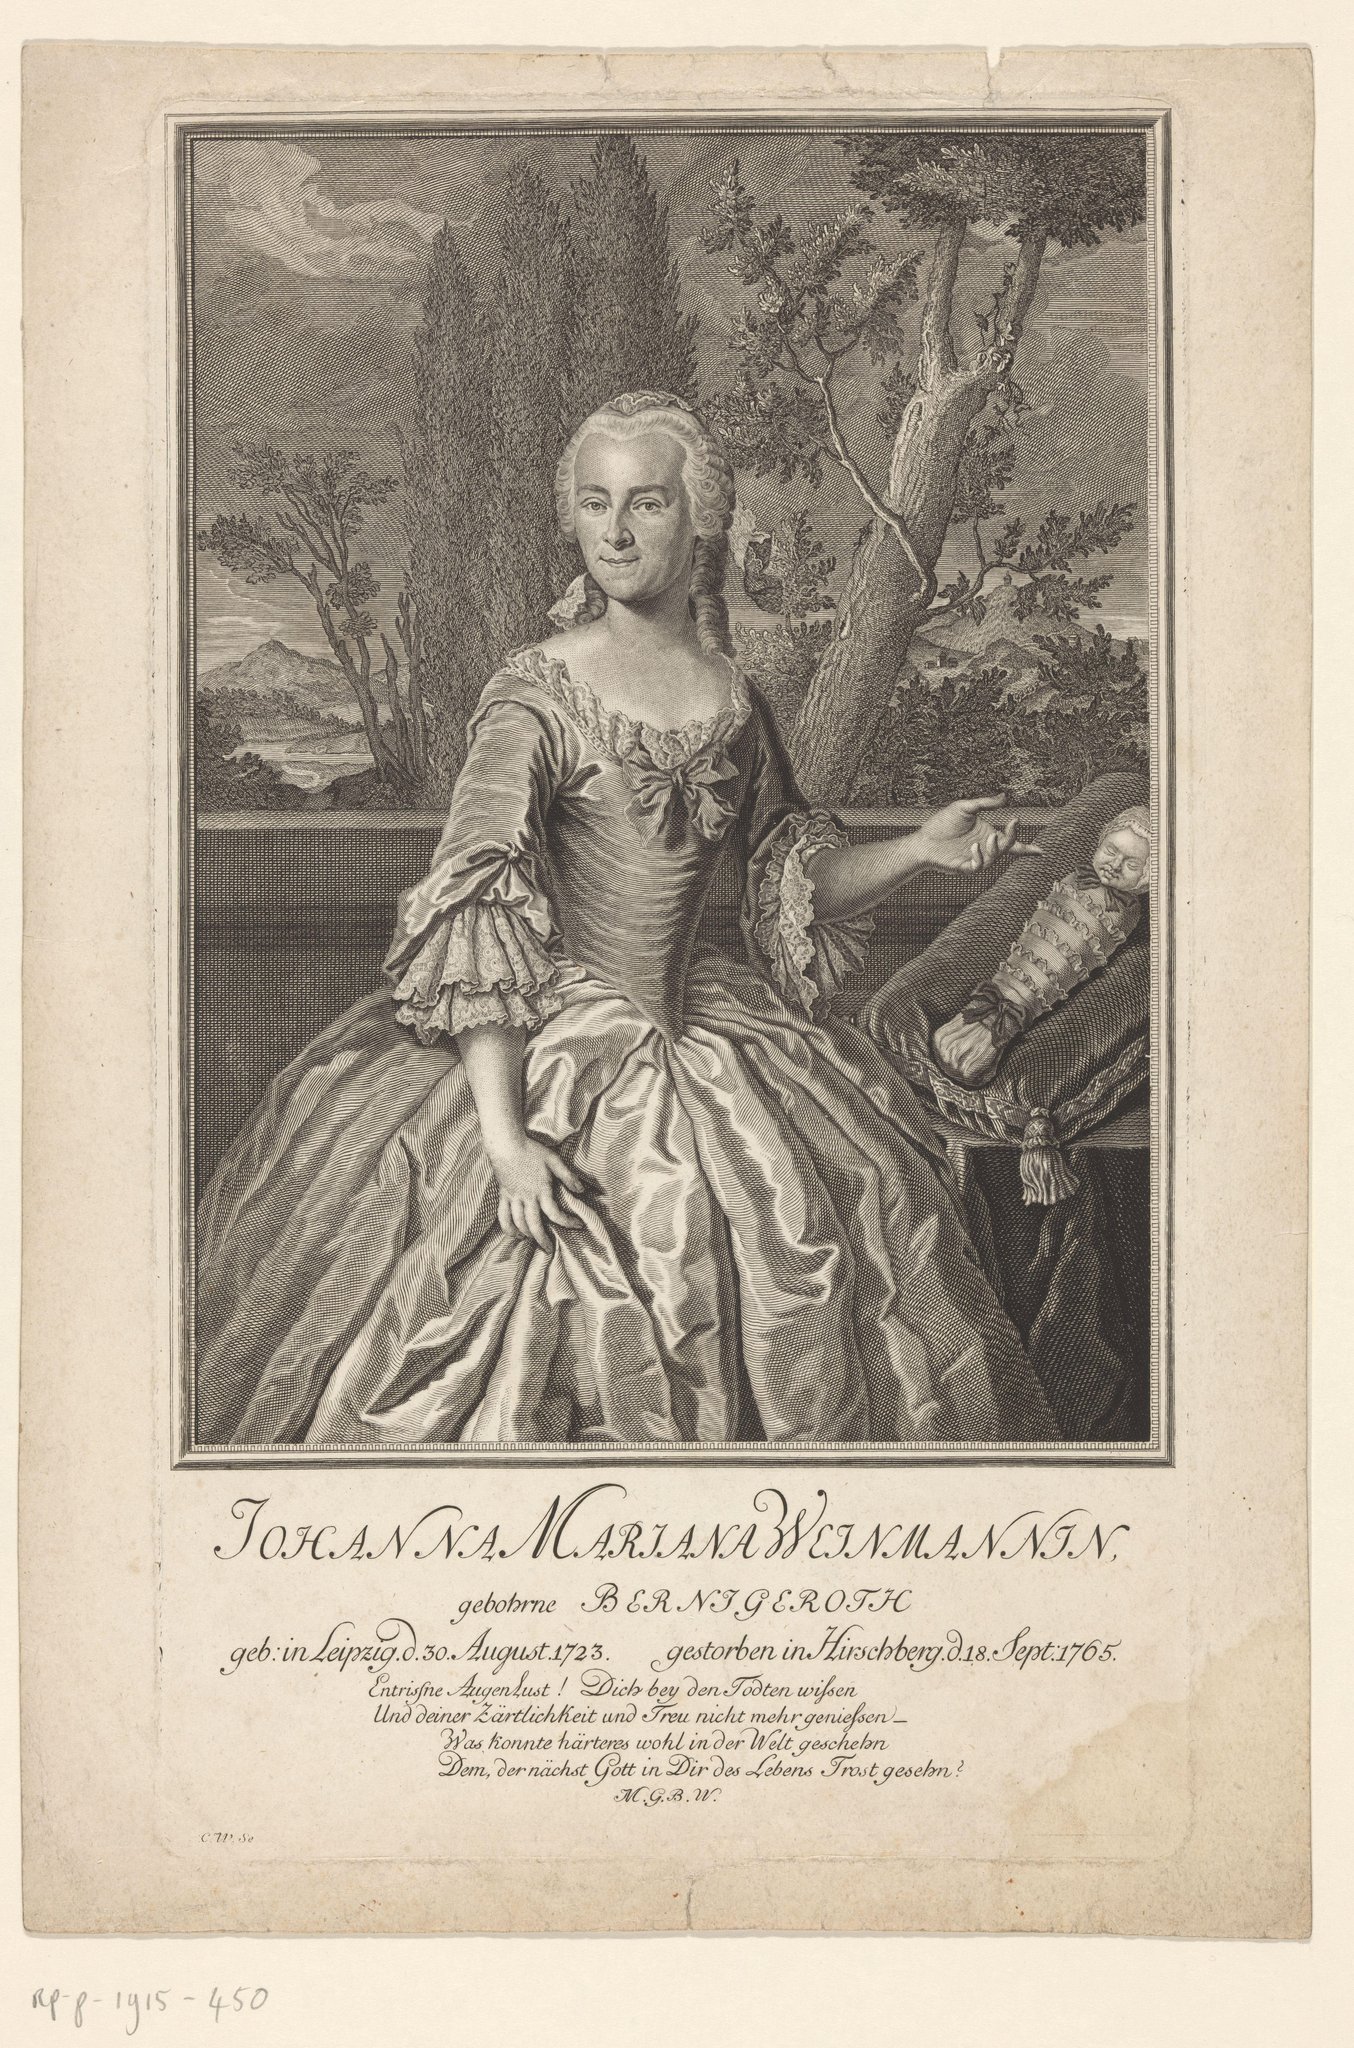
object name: print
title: Portret van Johanna Mariana Weinmann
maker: johann martin bernigeroth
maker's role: print maker, publisher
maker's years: 1713-1767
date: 1766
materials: paper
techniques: engraving, etching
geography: leipzig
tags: historical persons - bb - woman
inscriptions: collector's mark: Lugt 2228